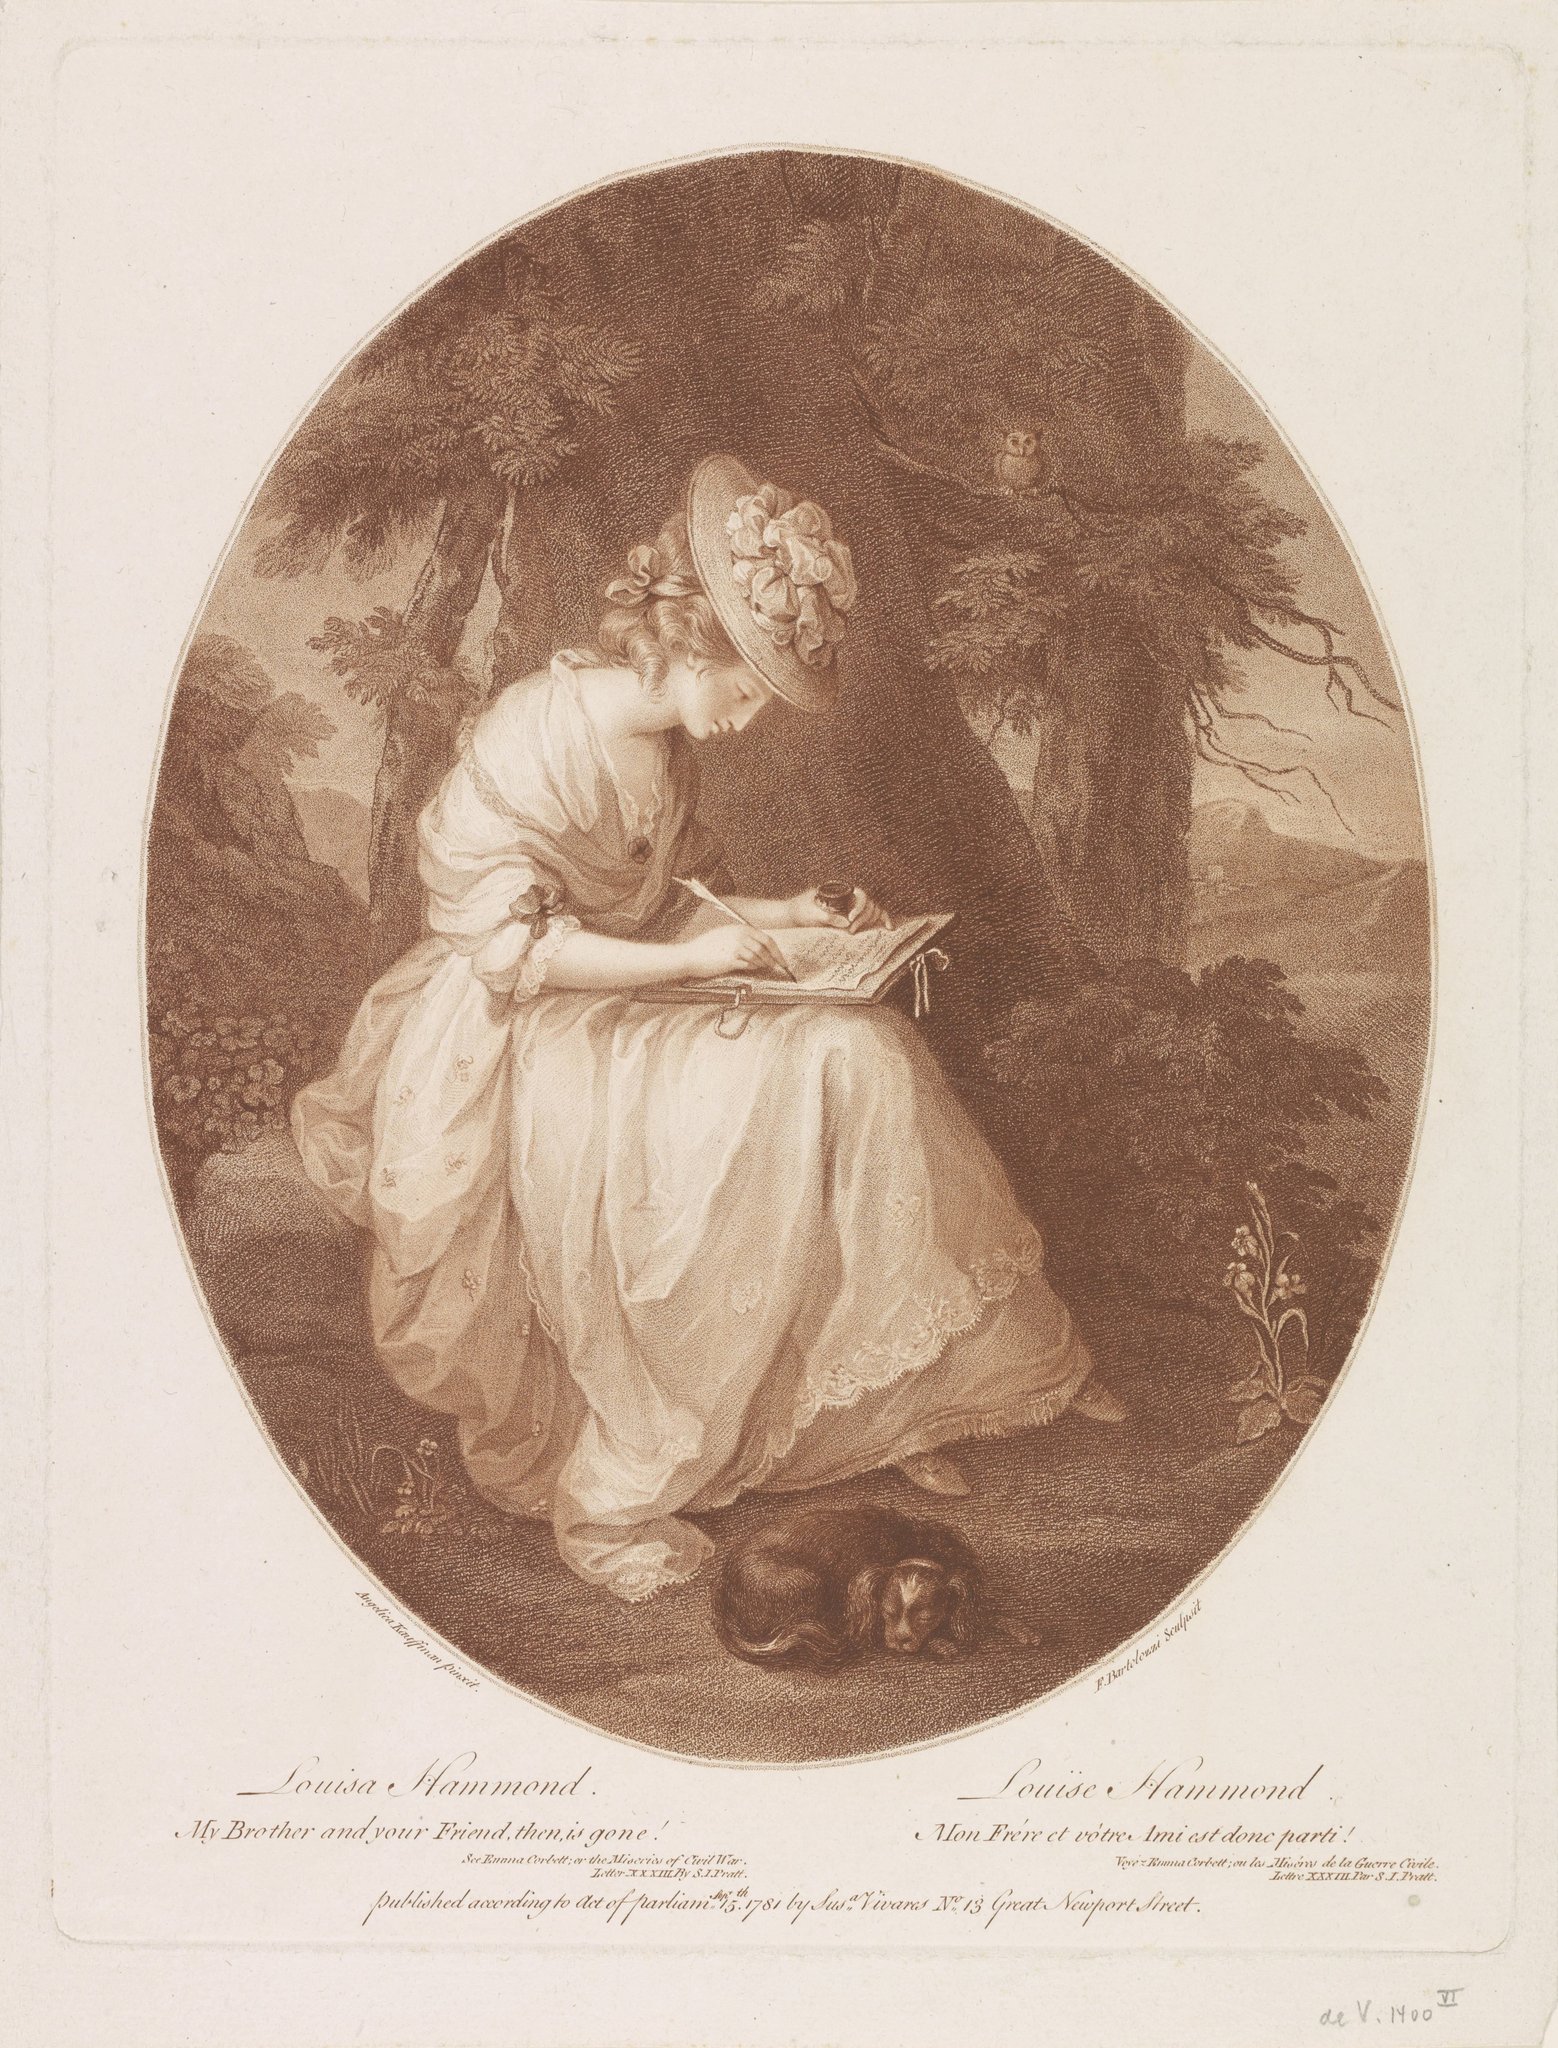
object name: print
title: Louisa Hammond schijvend onder een boom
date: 1781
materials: paper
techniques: etching, engraving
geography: london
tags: handwriting, writing as activity, writing boards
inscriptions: date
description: Louisa Hammond schijvend onder een boom. Bij haar voeten ligt een hond. In de boom zit een uil.